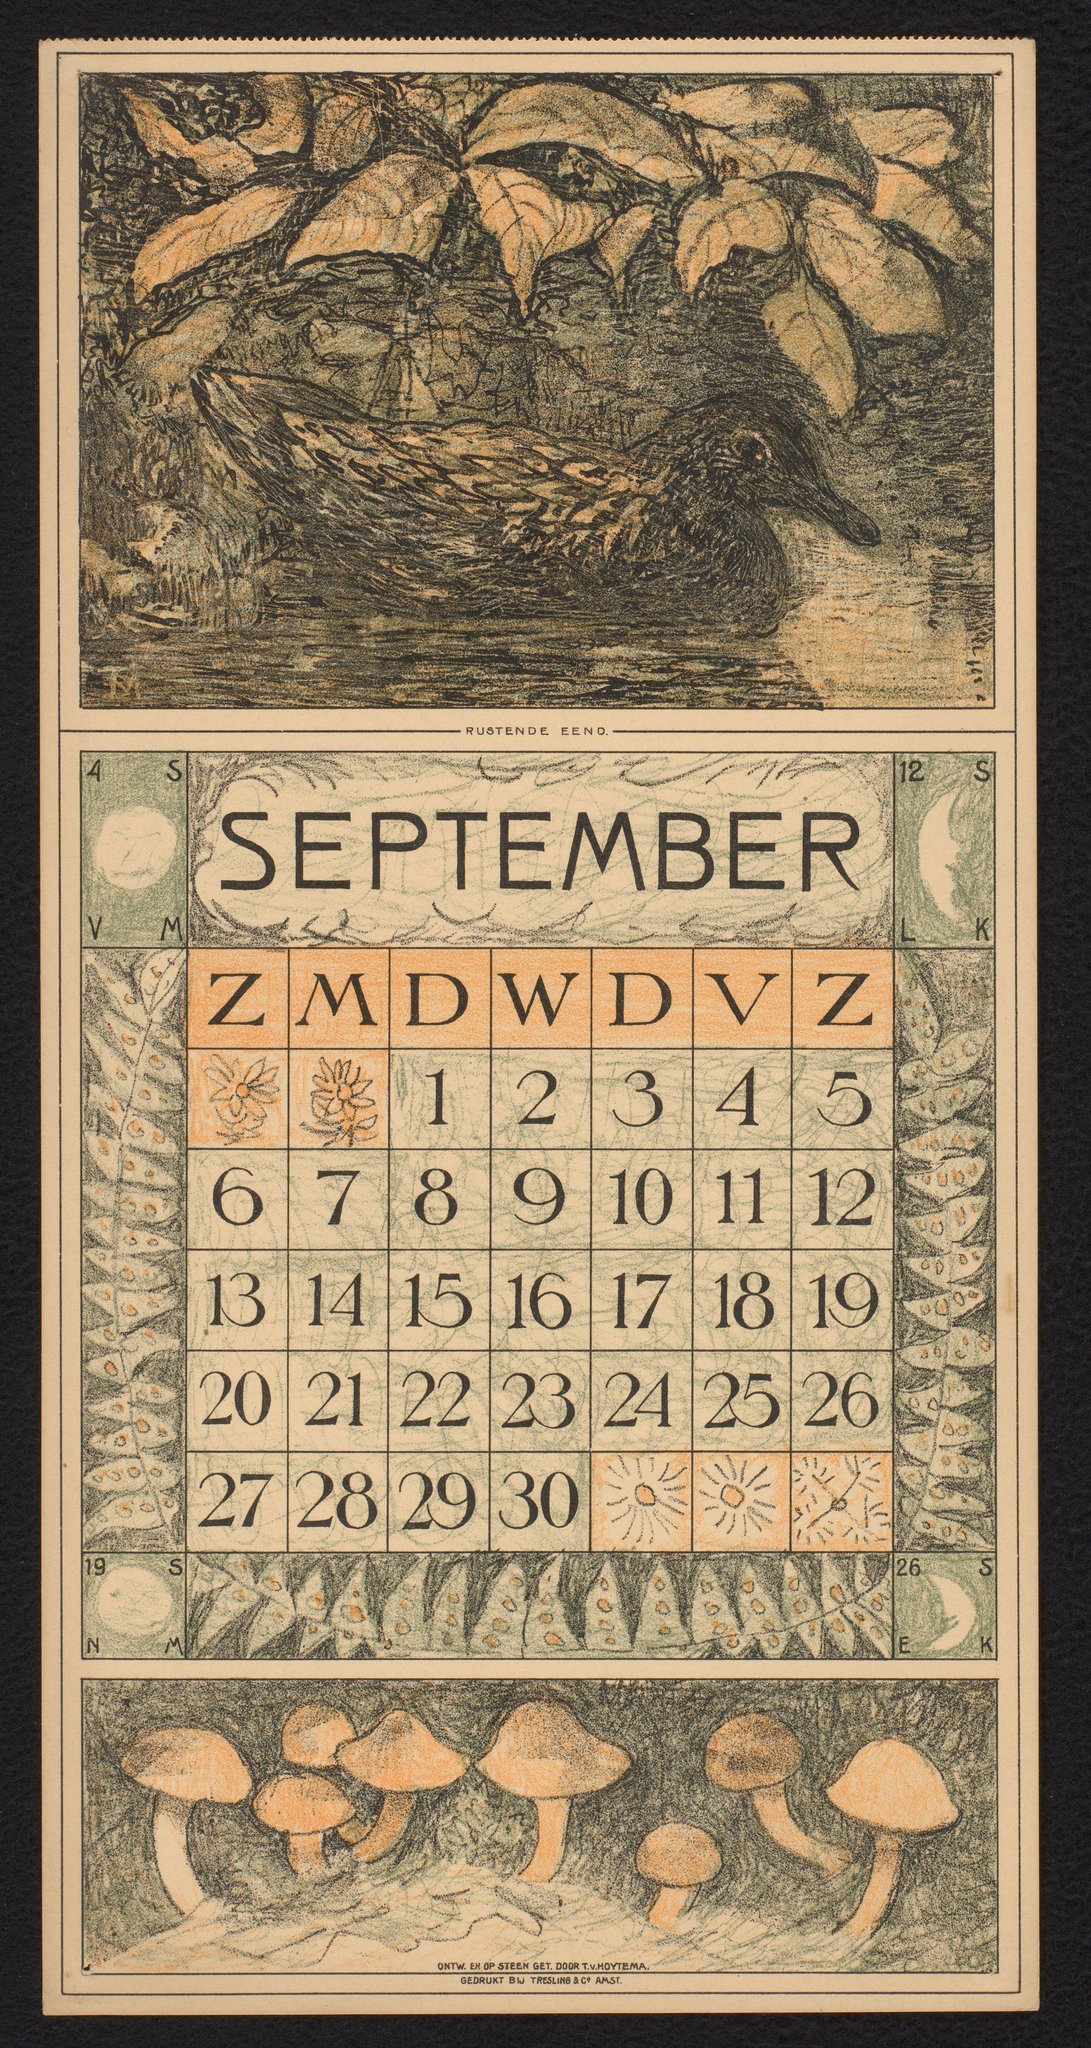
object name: print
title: Rustende eend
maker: theo van hoytema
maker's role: draughtsman, painter, print maker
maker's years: 1863-1917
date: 1913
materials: paper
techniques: lithograph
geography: amsterdam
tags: calendar, almanac, water-birds: duck